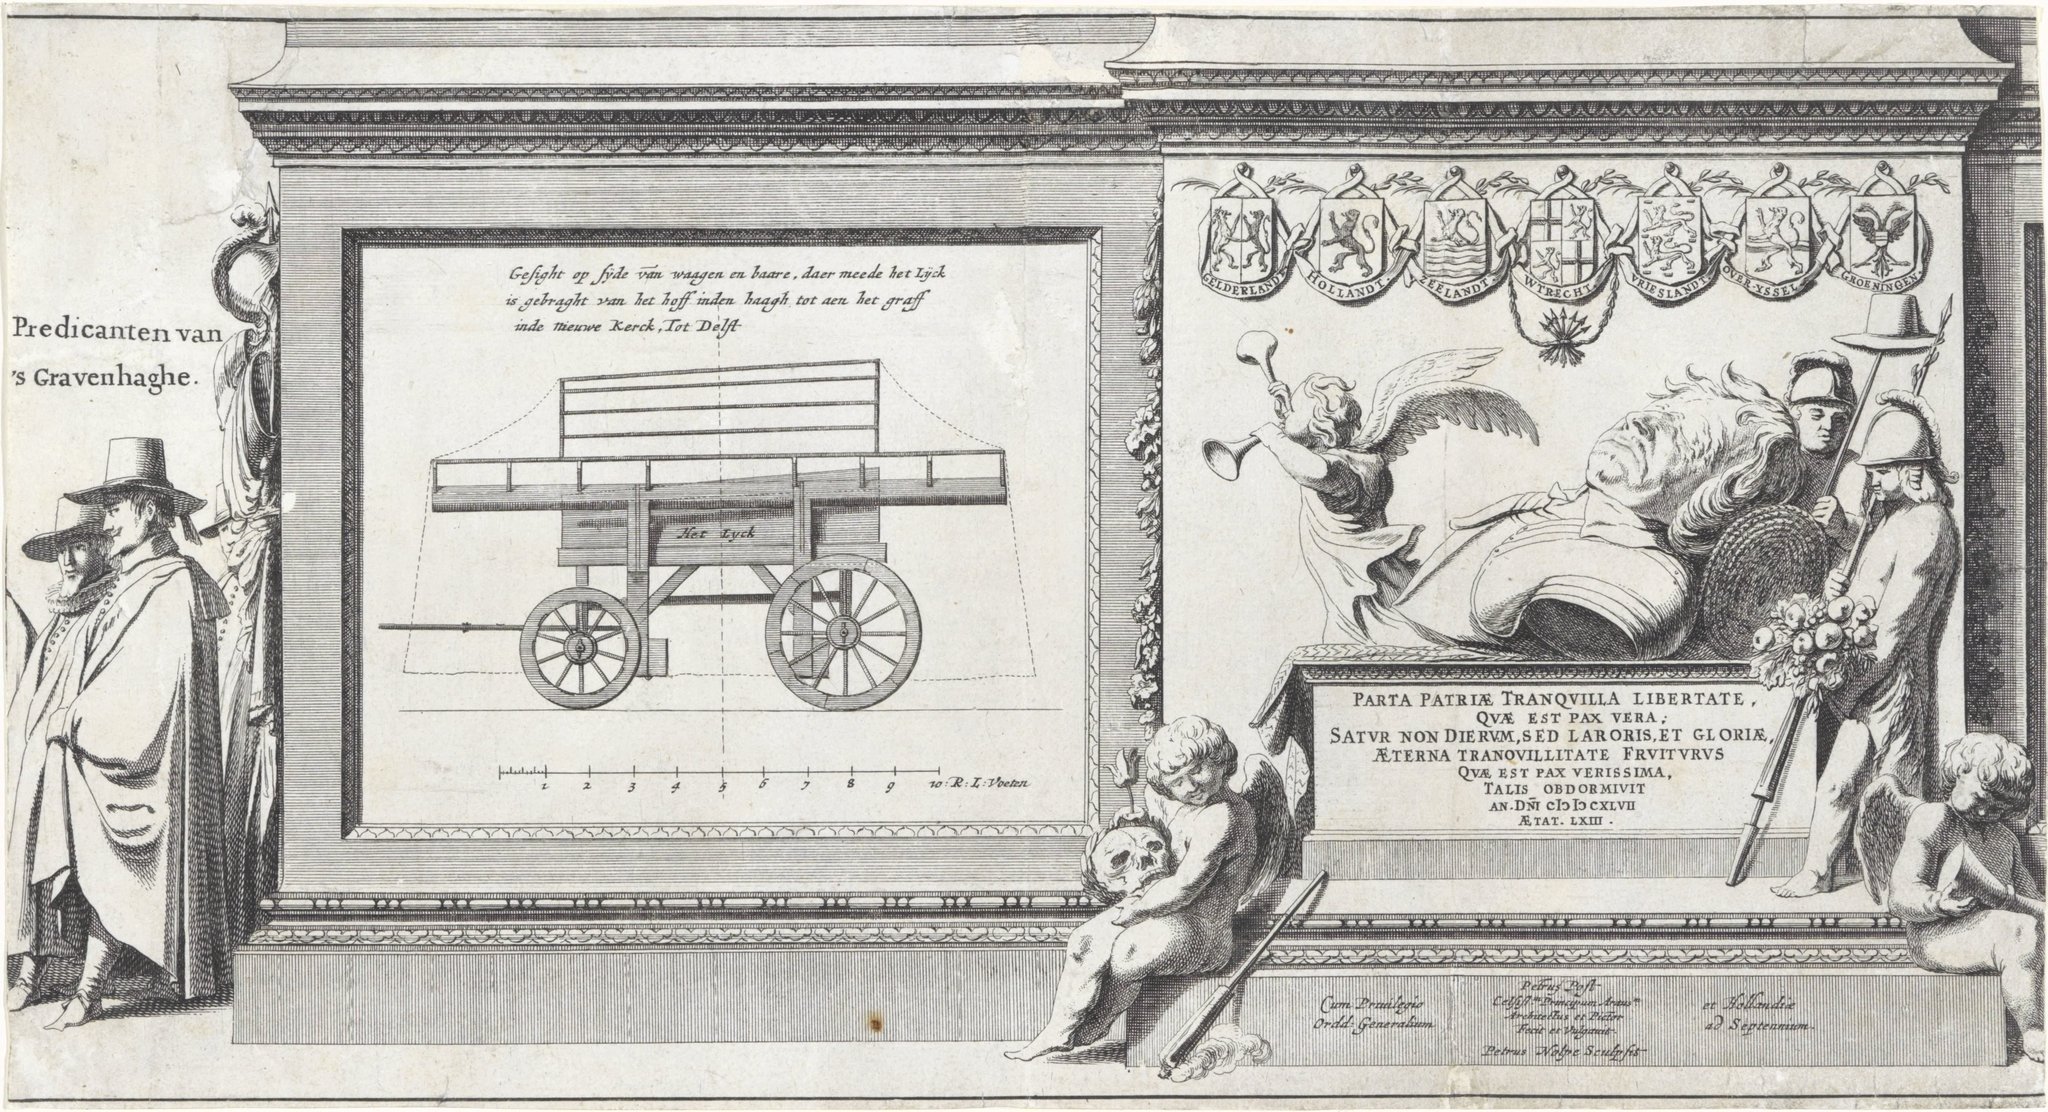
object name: print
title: De begrafenisstoet van stadhouder Frederik Hendrik te 's-Gravenhage in 1647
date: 1651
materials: paper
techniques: engraving, etching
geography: amsterdam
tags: cortege, funeral procession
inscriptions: collector's mark: Lugt 2228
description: De begrafenisstoet van stadhouder Frederik Hendrik te 's-Gravenhage op 10 mei 1647. Plaat nr. 30 met het laatste deel van de stoet met enkele predikanten, een grafmonument en een constructietekening van de lijkkoets. Onderdeel van een serie van 30 platen en 20 tekstbladen, bedoeld om aan elkaar geplakt te worden.